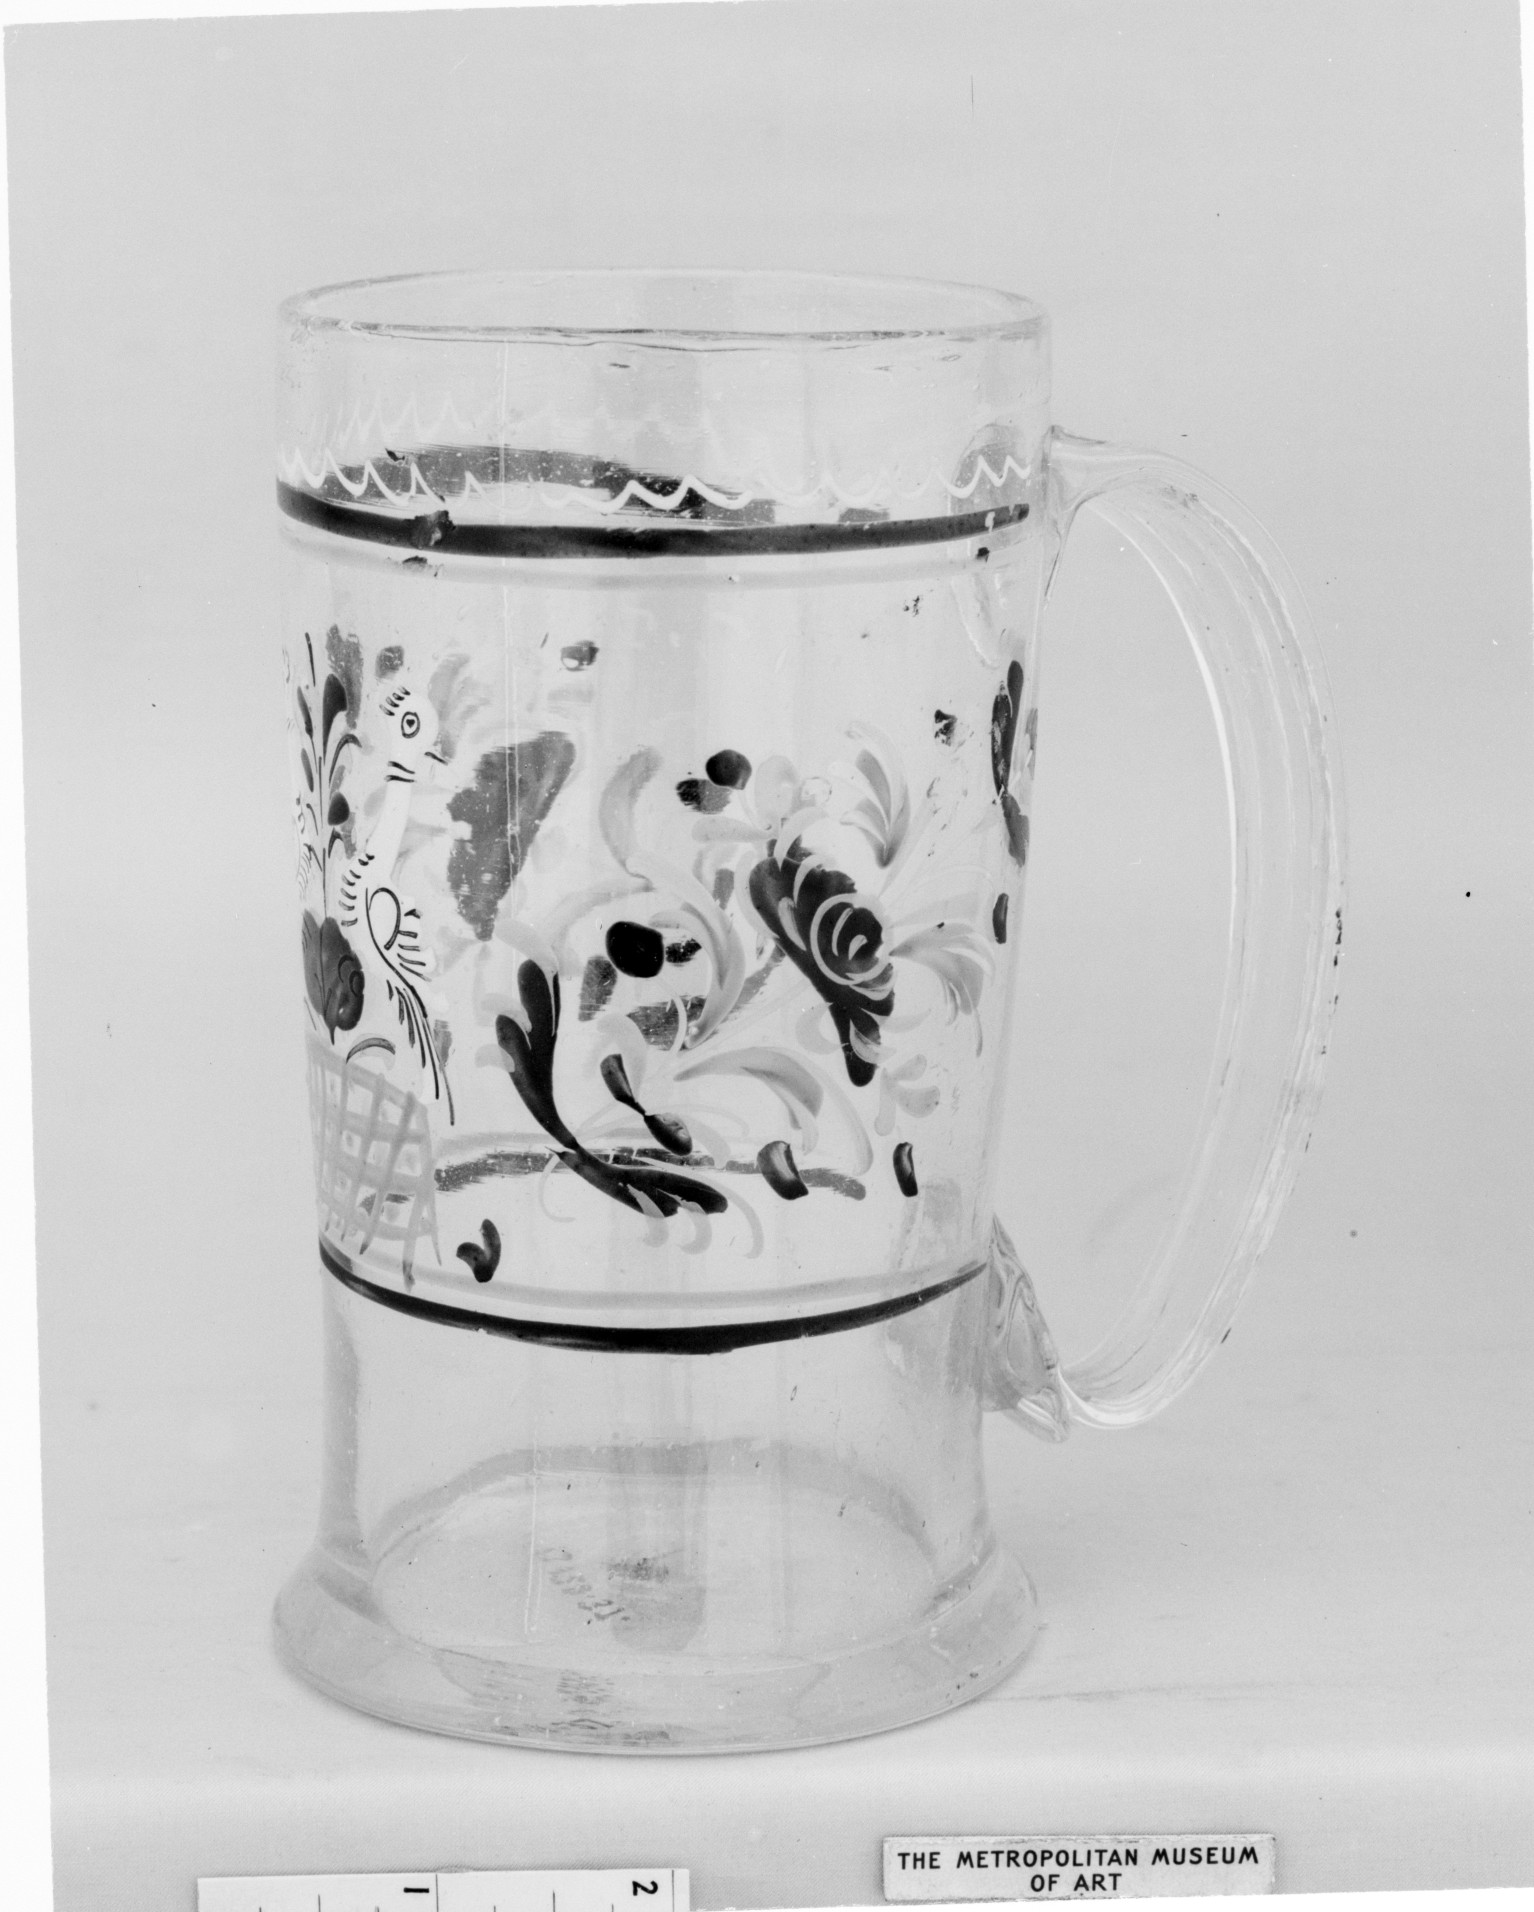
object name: mug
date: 1701-1800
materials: enamel, glass, lead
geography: czech republic